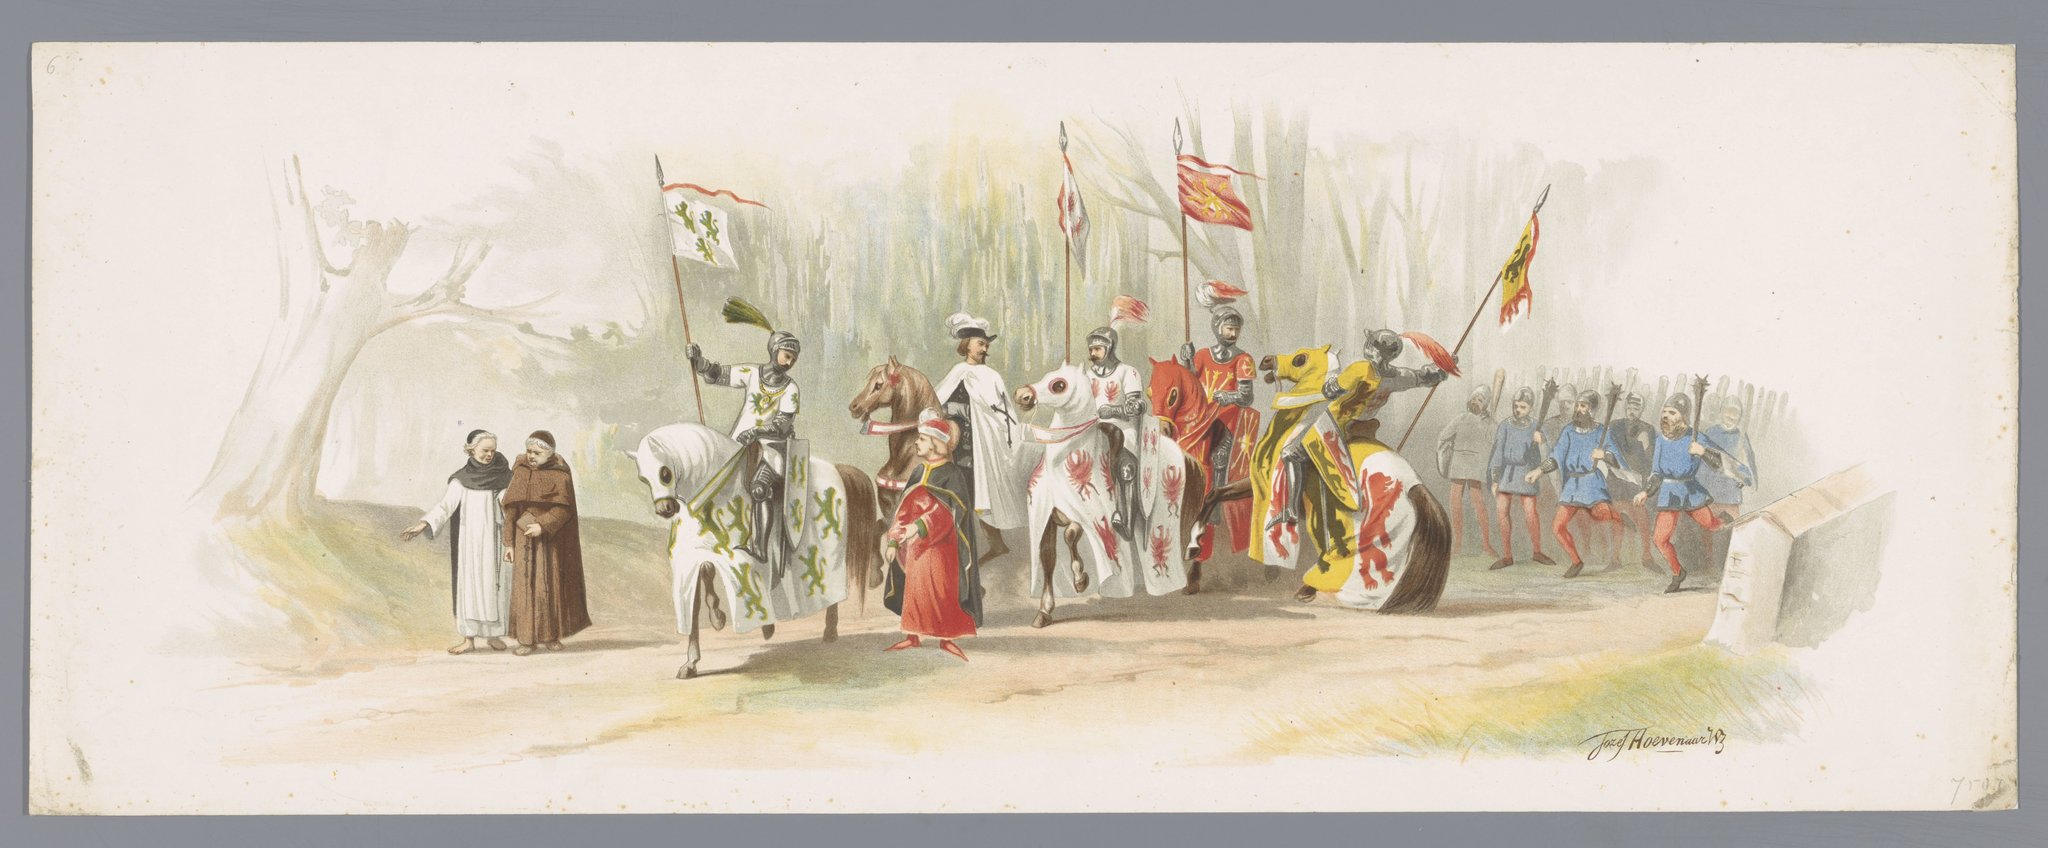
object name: print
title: XLVIII. Lustrum der Utrechtsche Hoogeschool. Intocht van Hertog Karel den Stoute te Zutfen, IV Augustus MCCCCLXXIII. Gekostumeerde optocht van Heeren Studenten, gehouden te Utrecht den 27 Juni 1876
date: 1876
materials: paper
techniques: chromolithography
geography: netherlands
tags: earl, charles the bold (duke of burgundy), students' pageant, costumes used in pageants, commemoration of the founding of a university, utrecht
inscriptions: collector's mark: Lugt 2228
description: Zesde deel van de optocht. Onderdeel van een serie van zeven platen plus titelprent en verklaring van de gecostumeerde optocht georganiseerd door de studenten van de Utrechtse Hogeschool ter viering van de 48e lustrum op 27 juni 1876. De optocht stelt voor de intocht van Karel te Stoute te Zutphen op 4 augustus 1473.